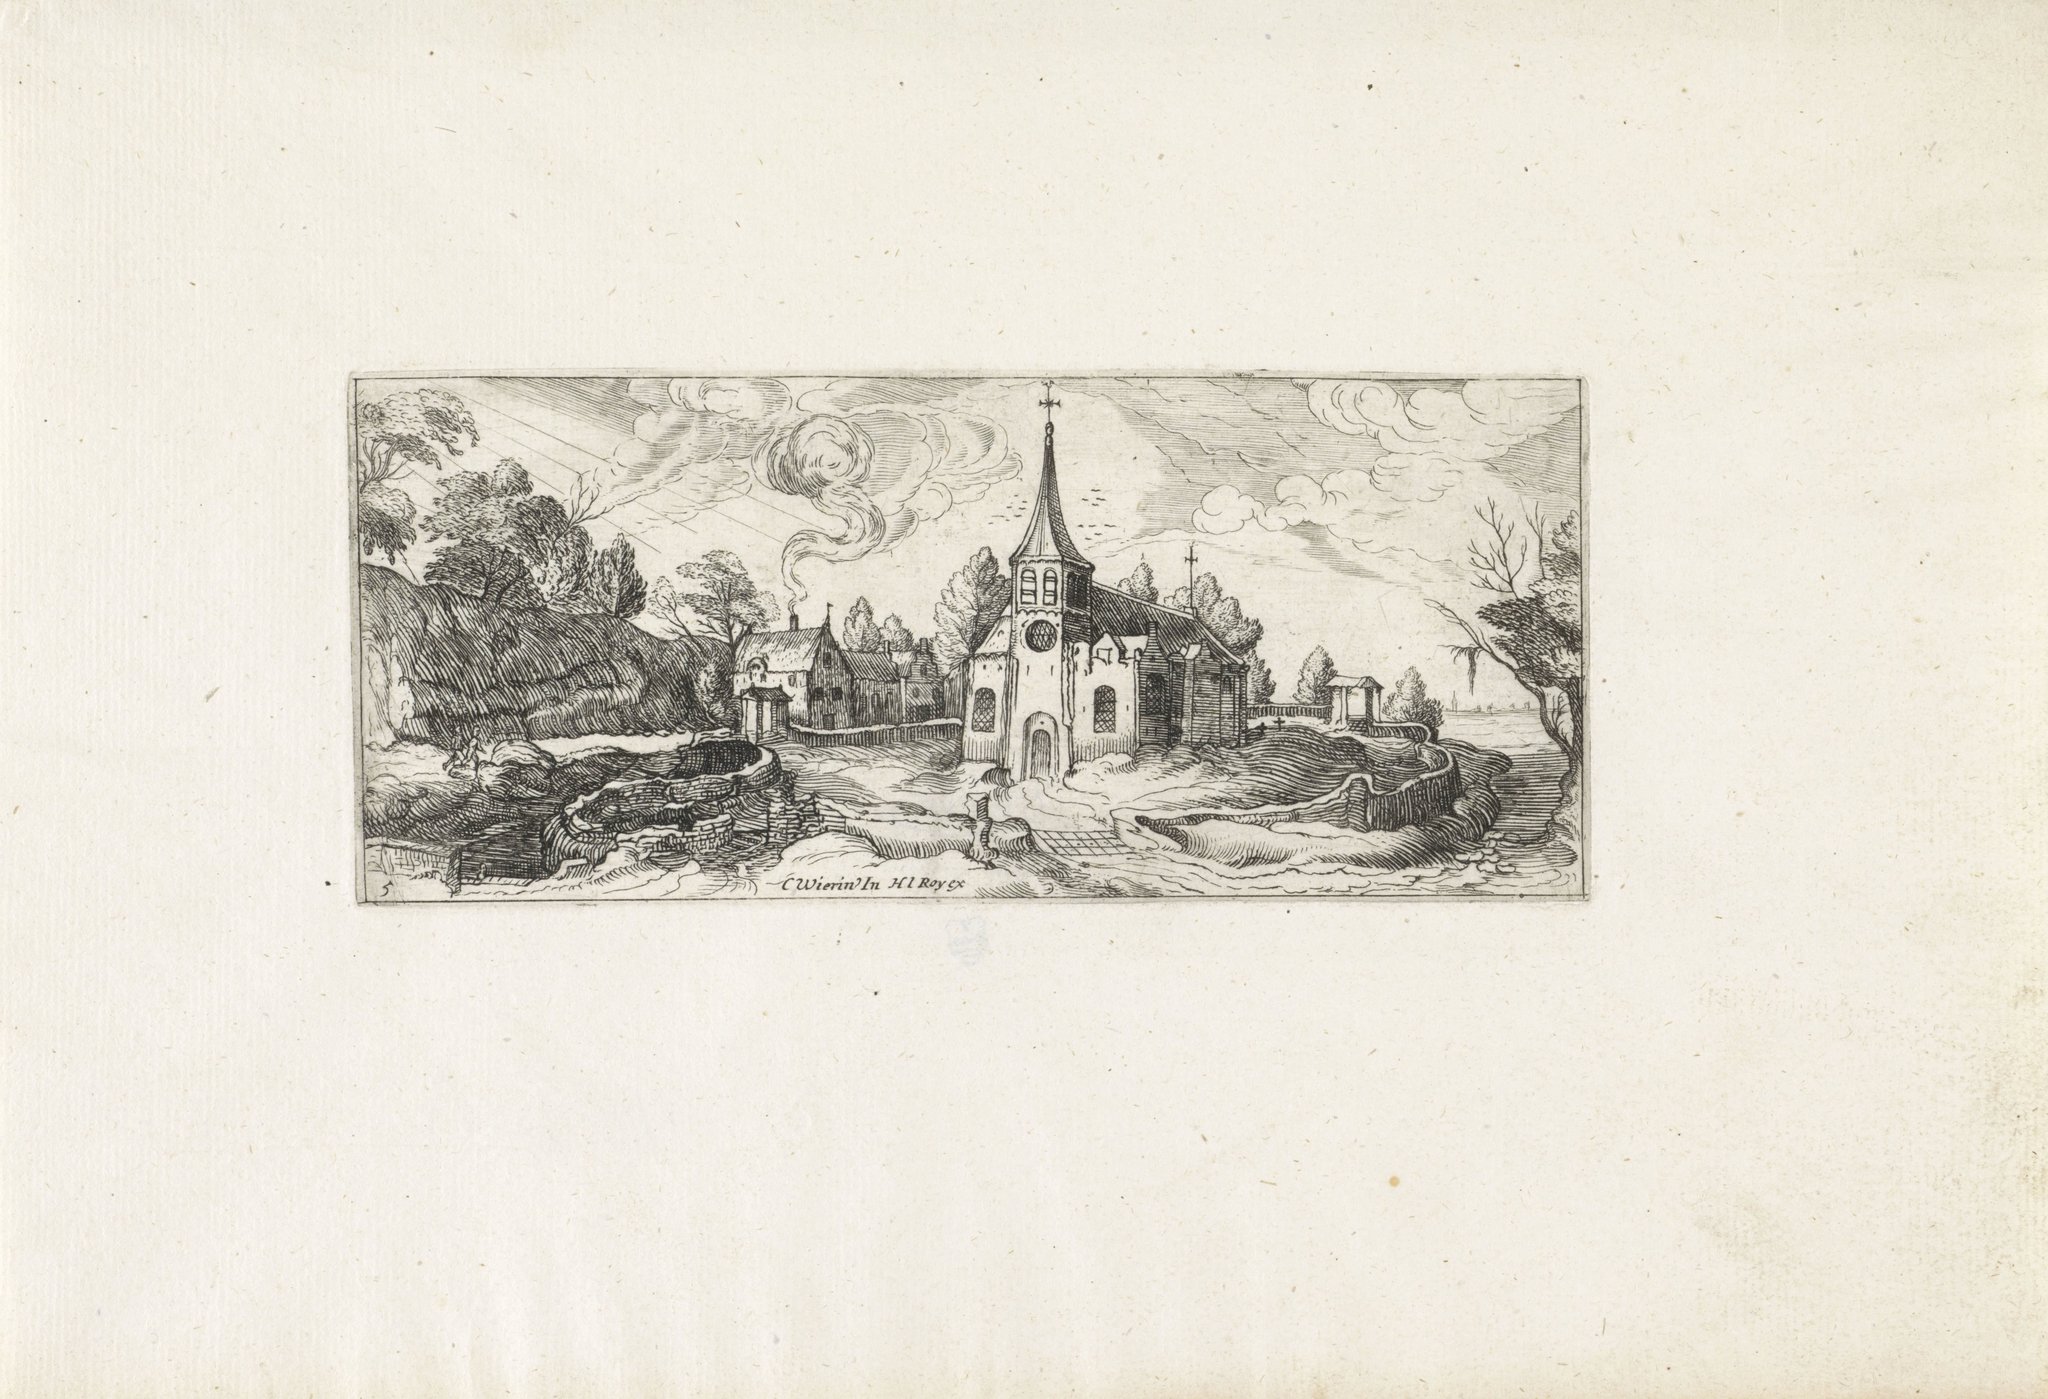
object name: print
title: Landschap met een gezicht op een kerk in een dorp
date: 1614-1618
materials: paper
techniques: etching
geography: haarlem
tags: church (exterior)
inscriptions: collector's mark: Lugt 2760, collector's mark: Lugt 2228